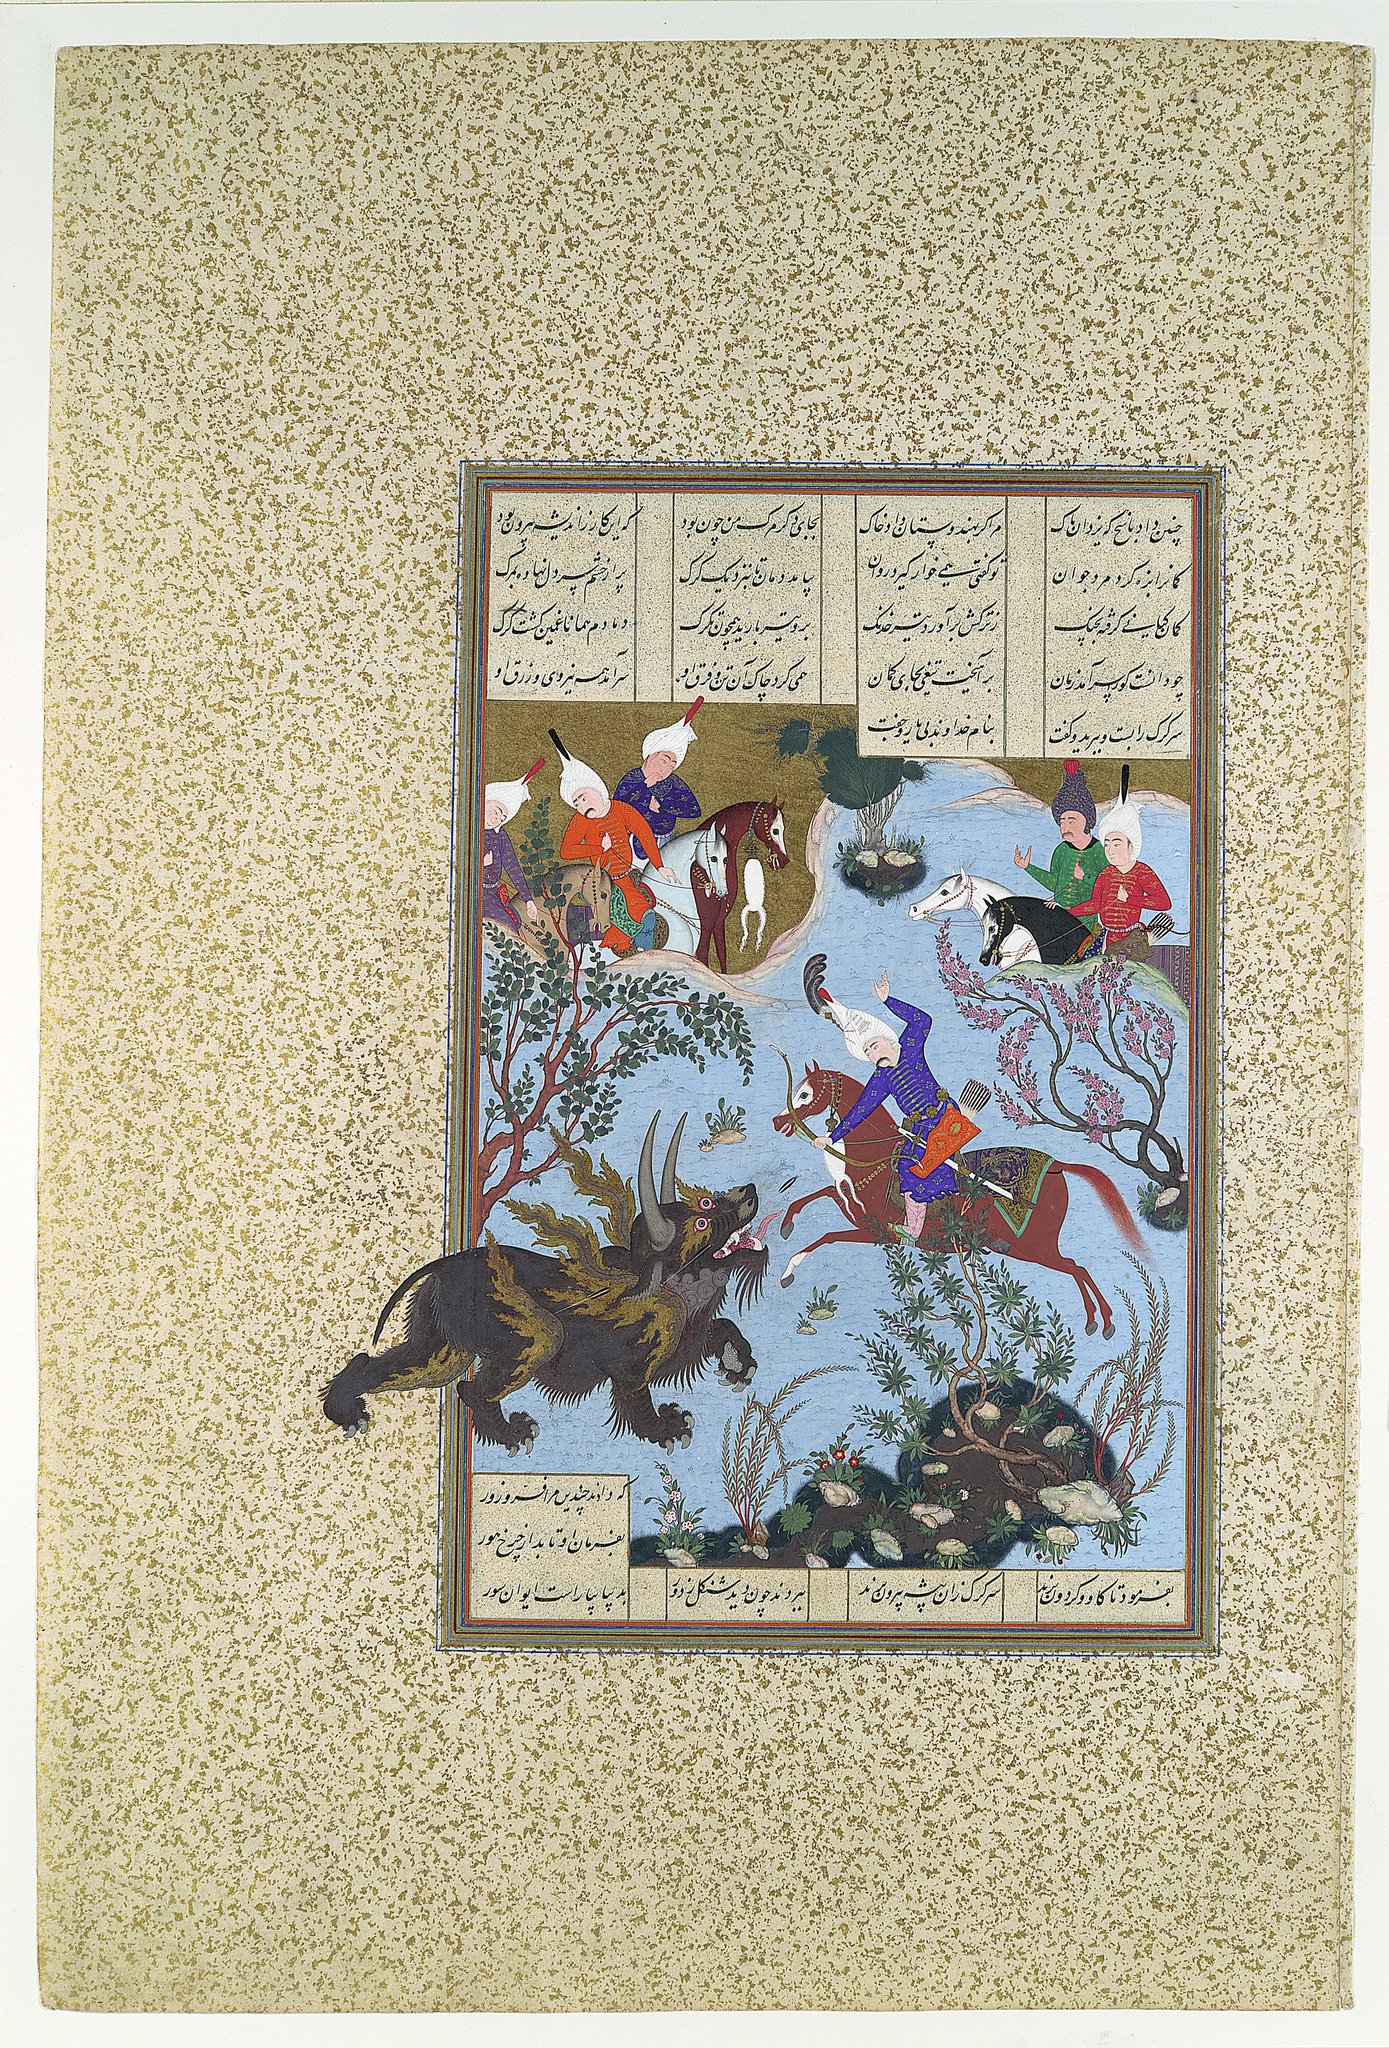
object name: folio from an illustrated manuscript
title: "Bahram Gur Slays the Rhino-Wolf", Folio 586r from the Shahnama (Book of Kings) of Shah Tahmasp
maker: abu'l qasim firdausi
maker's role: author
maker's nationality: iranian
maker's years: 935-1020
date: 1530-1535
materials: gold, ink, paper, silver, watercolor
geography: iran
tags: animals,poetry,kings,horses